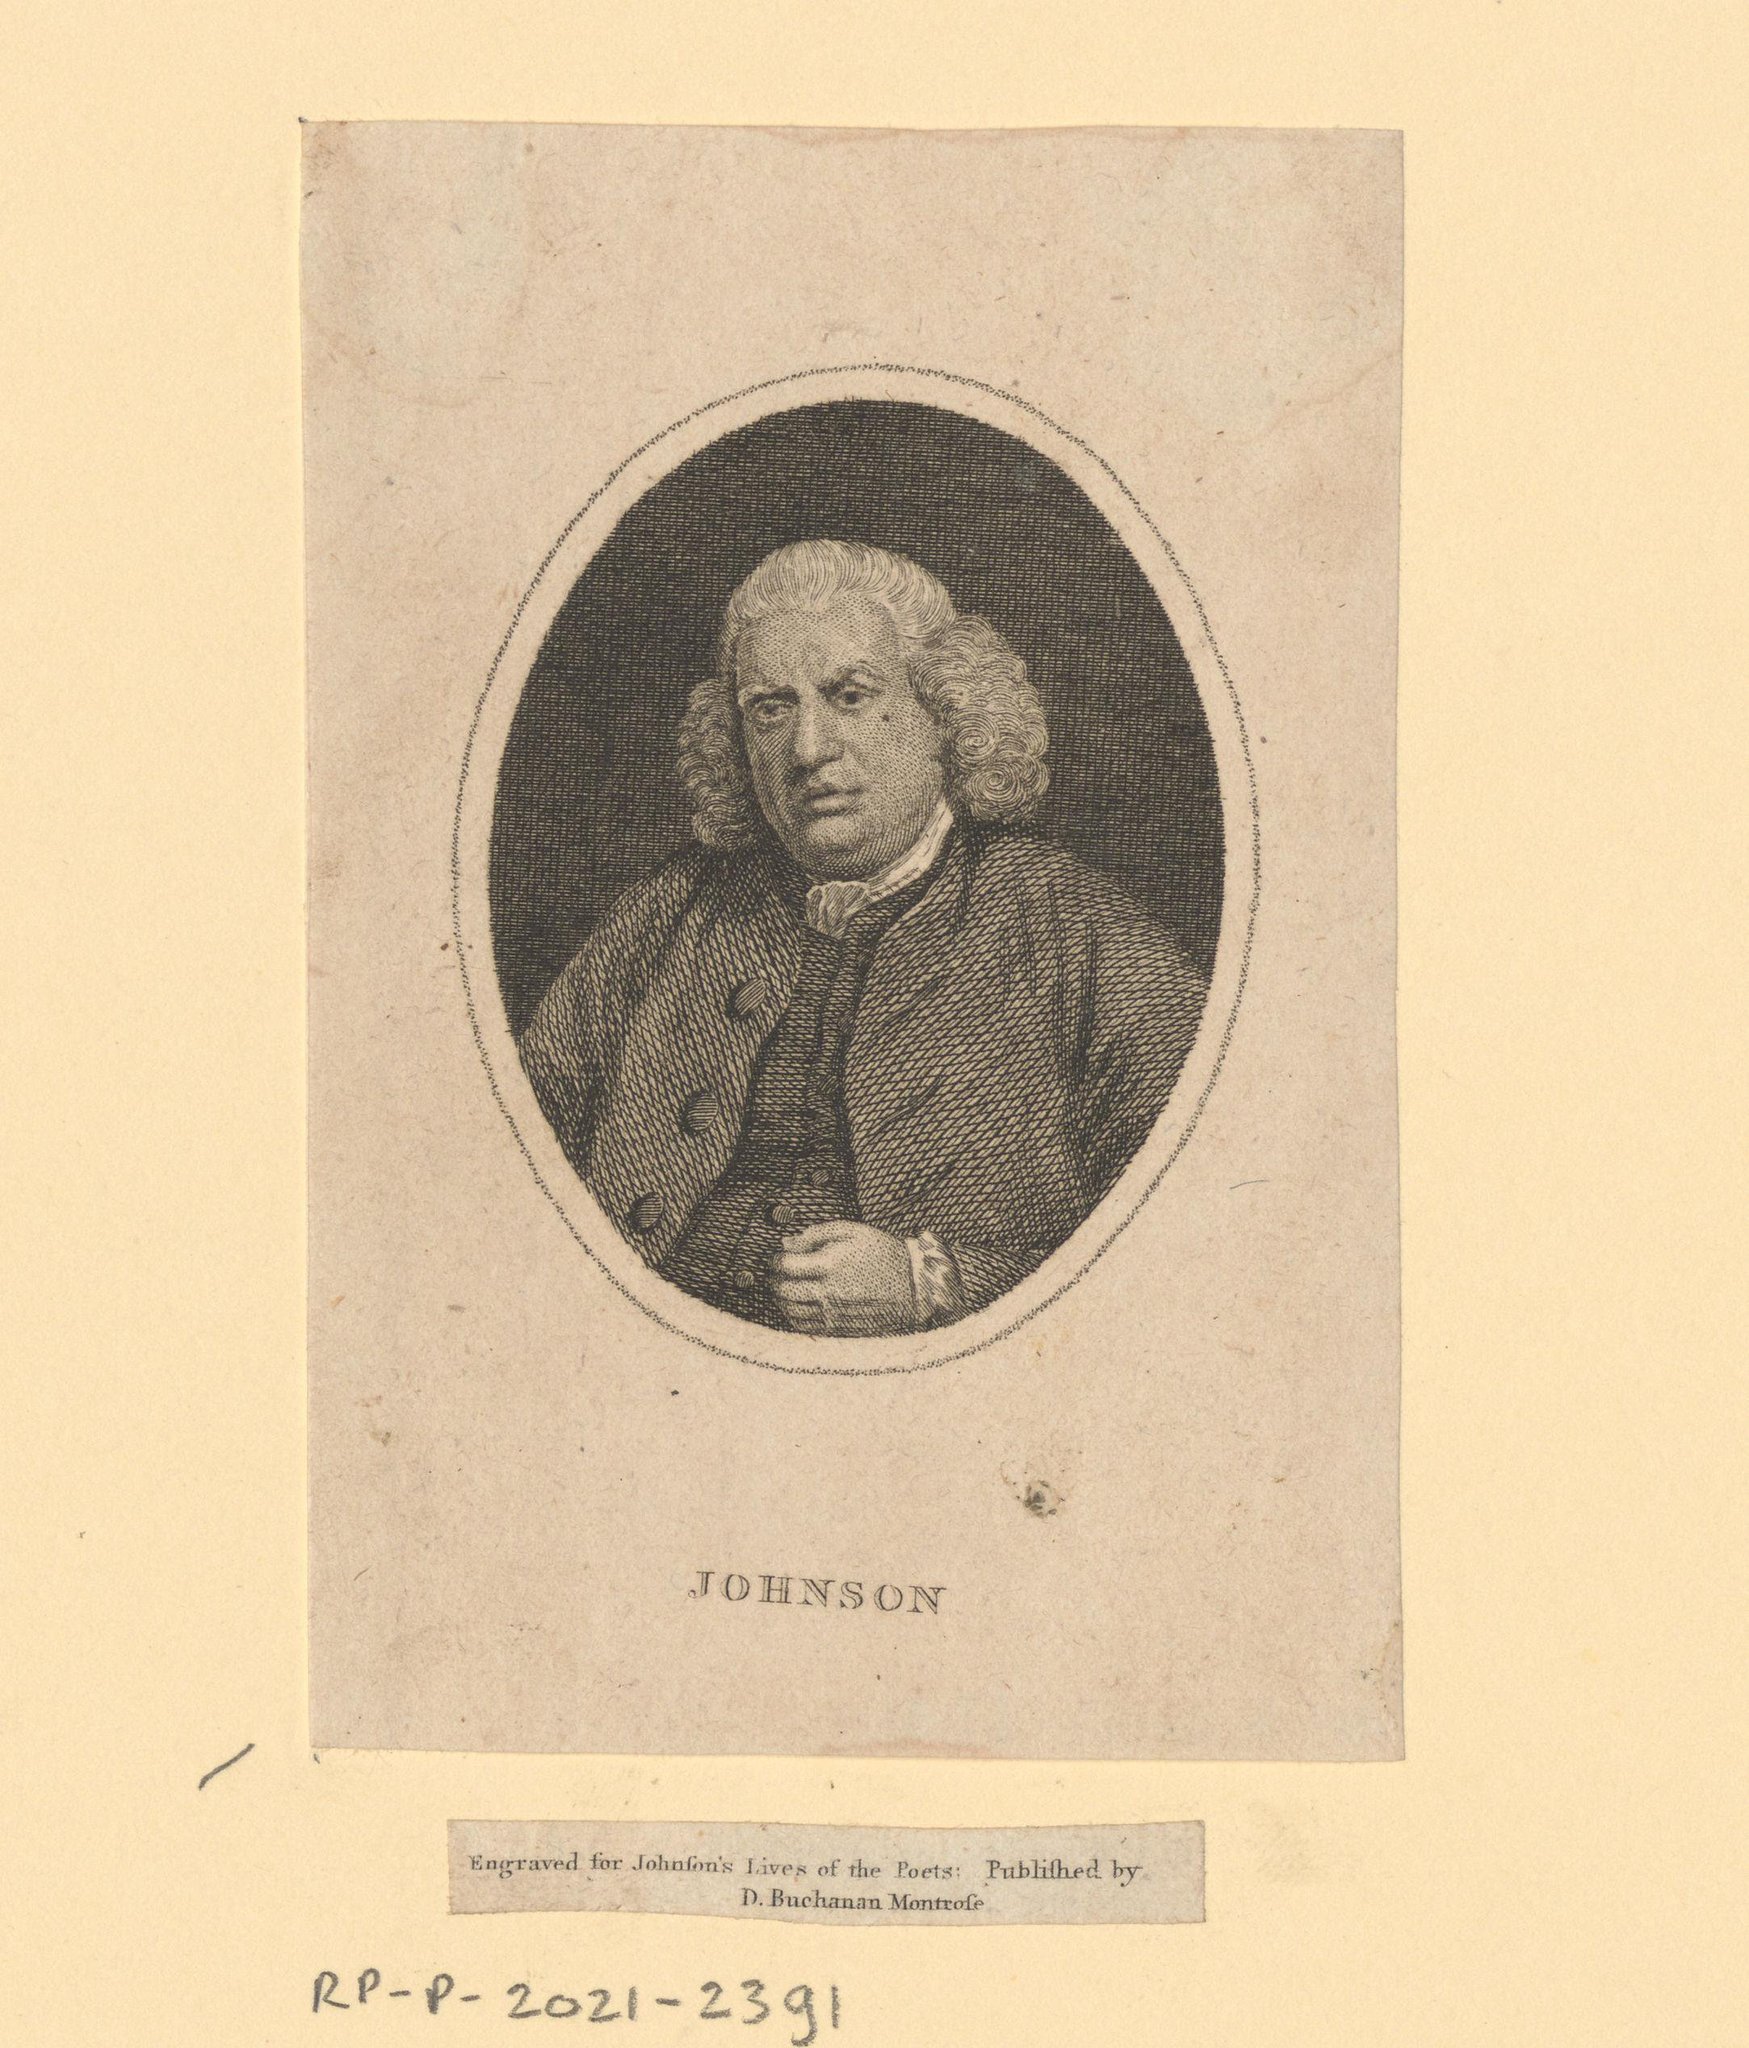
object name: print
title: Portret van Samuel Johnson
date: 1800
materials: paper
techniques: engraving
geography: montrose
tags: historical persons, portrait of a writer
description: Prent mogelijk uit: Johnson, Samuel. The Lives of the Most Eminent English Poets. 4 dln. Montrose: David Buchanan, 1800.